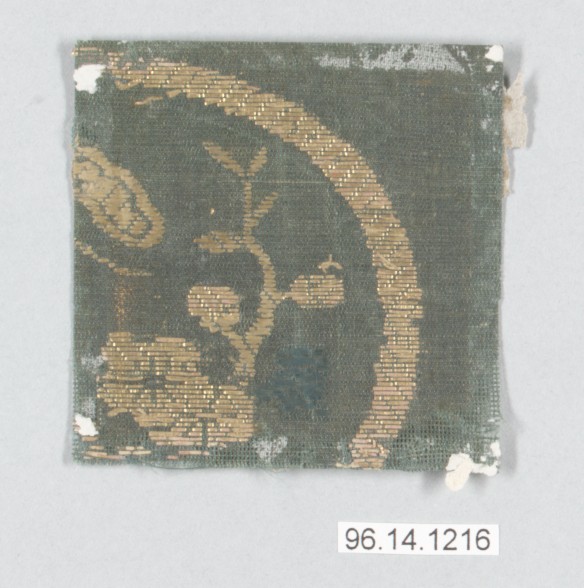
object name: piece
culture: japanese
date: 1867-1900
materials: metal thread, silk